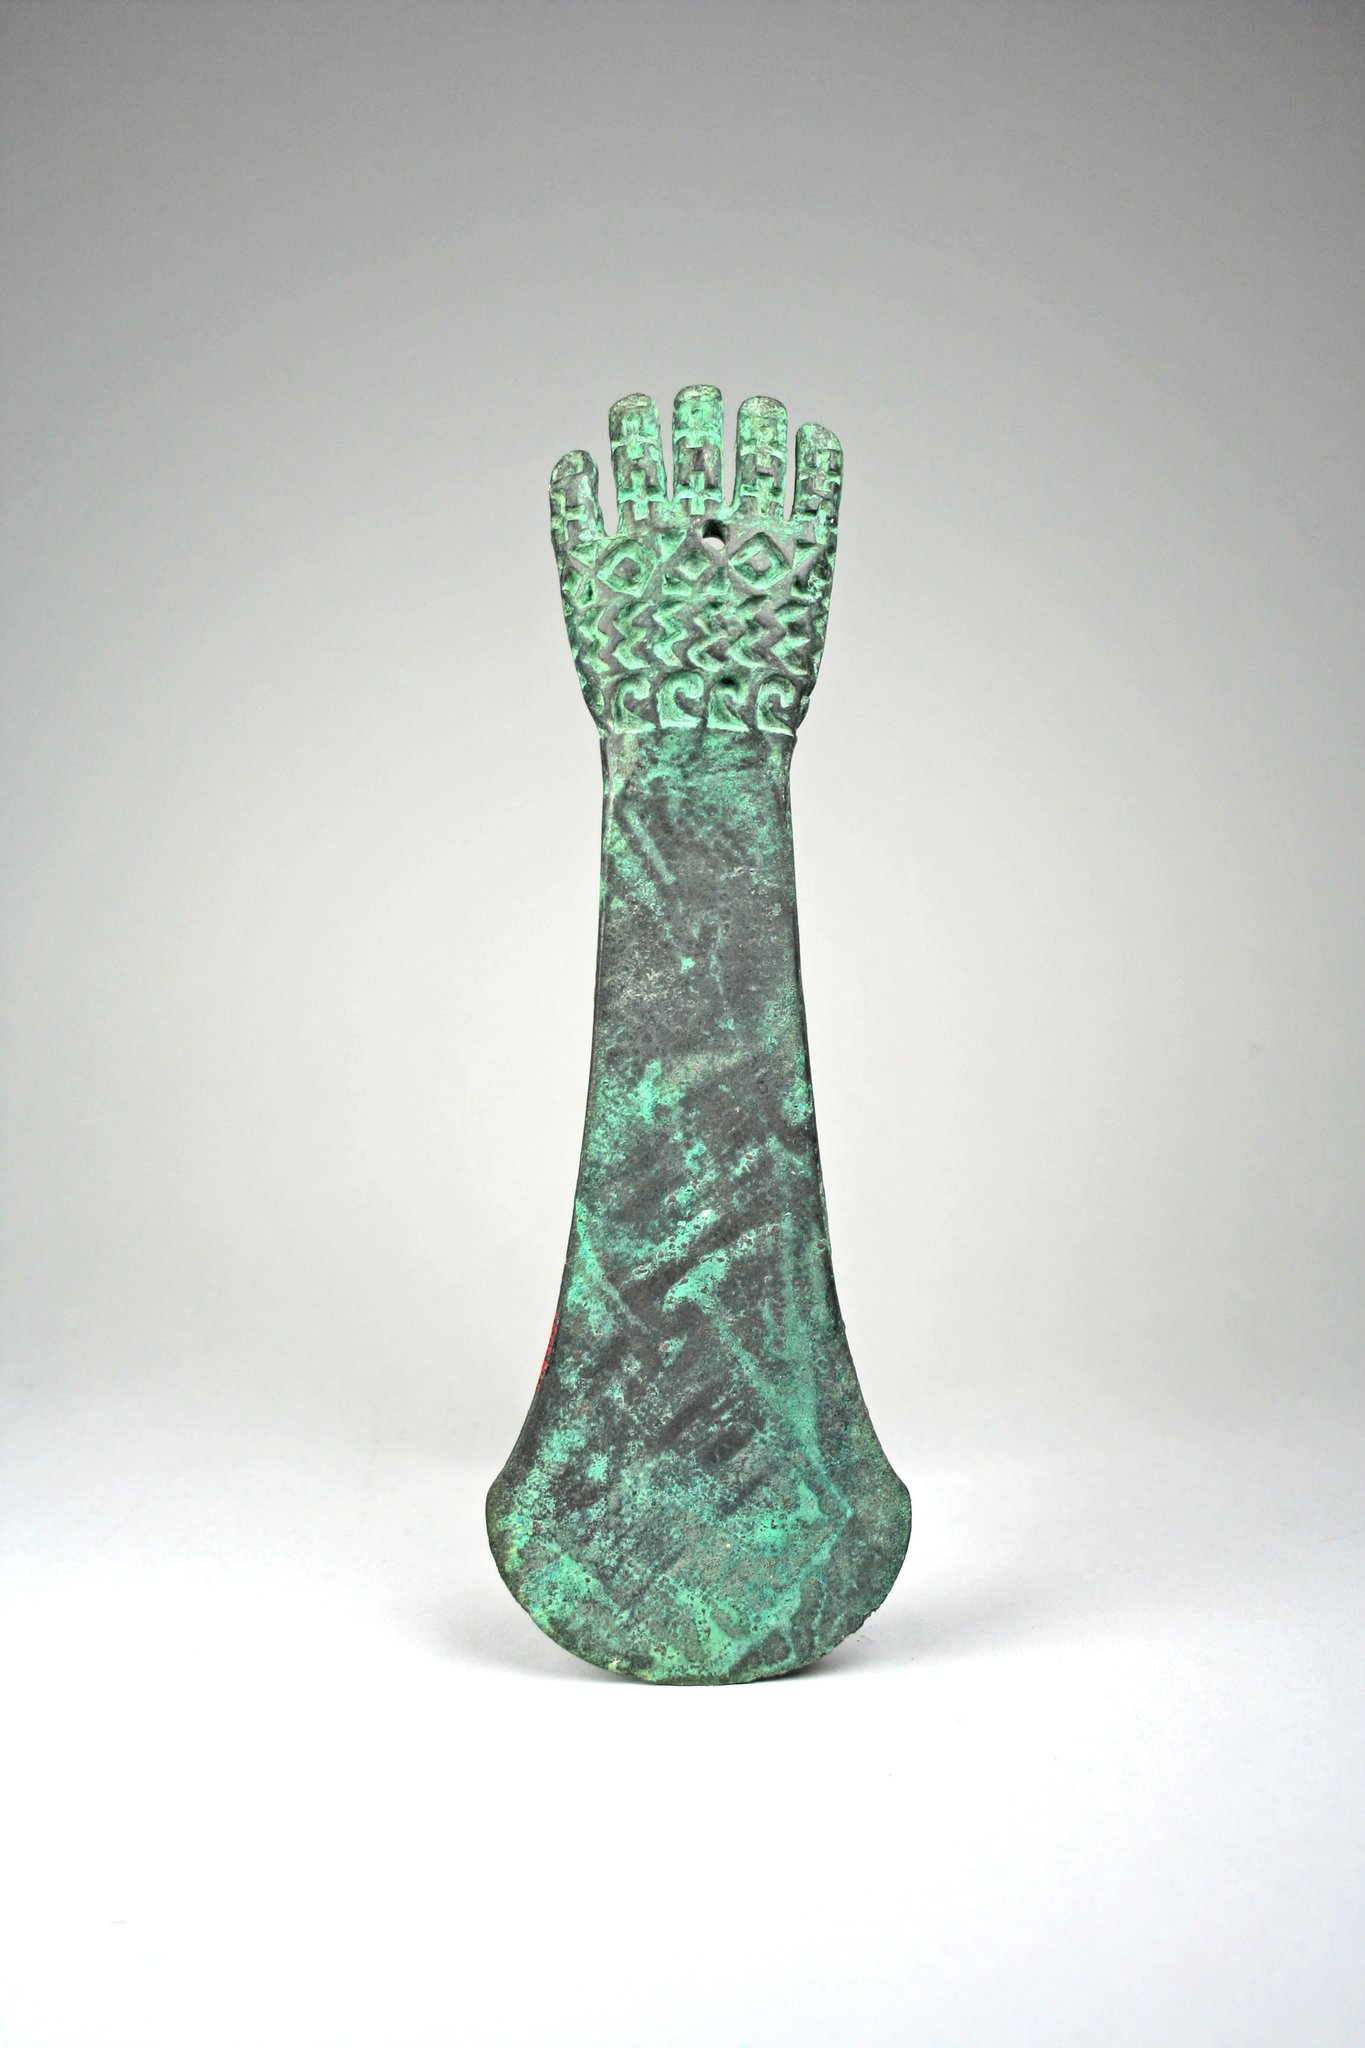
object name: knife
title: Knife, Hand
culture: moche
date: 1-300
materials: copper, gold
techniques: casting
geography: peru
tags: hands